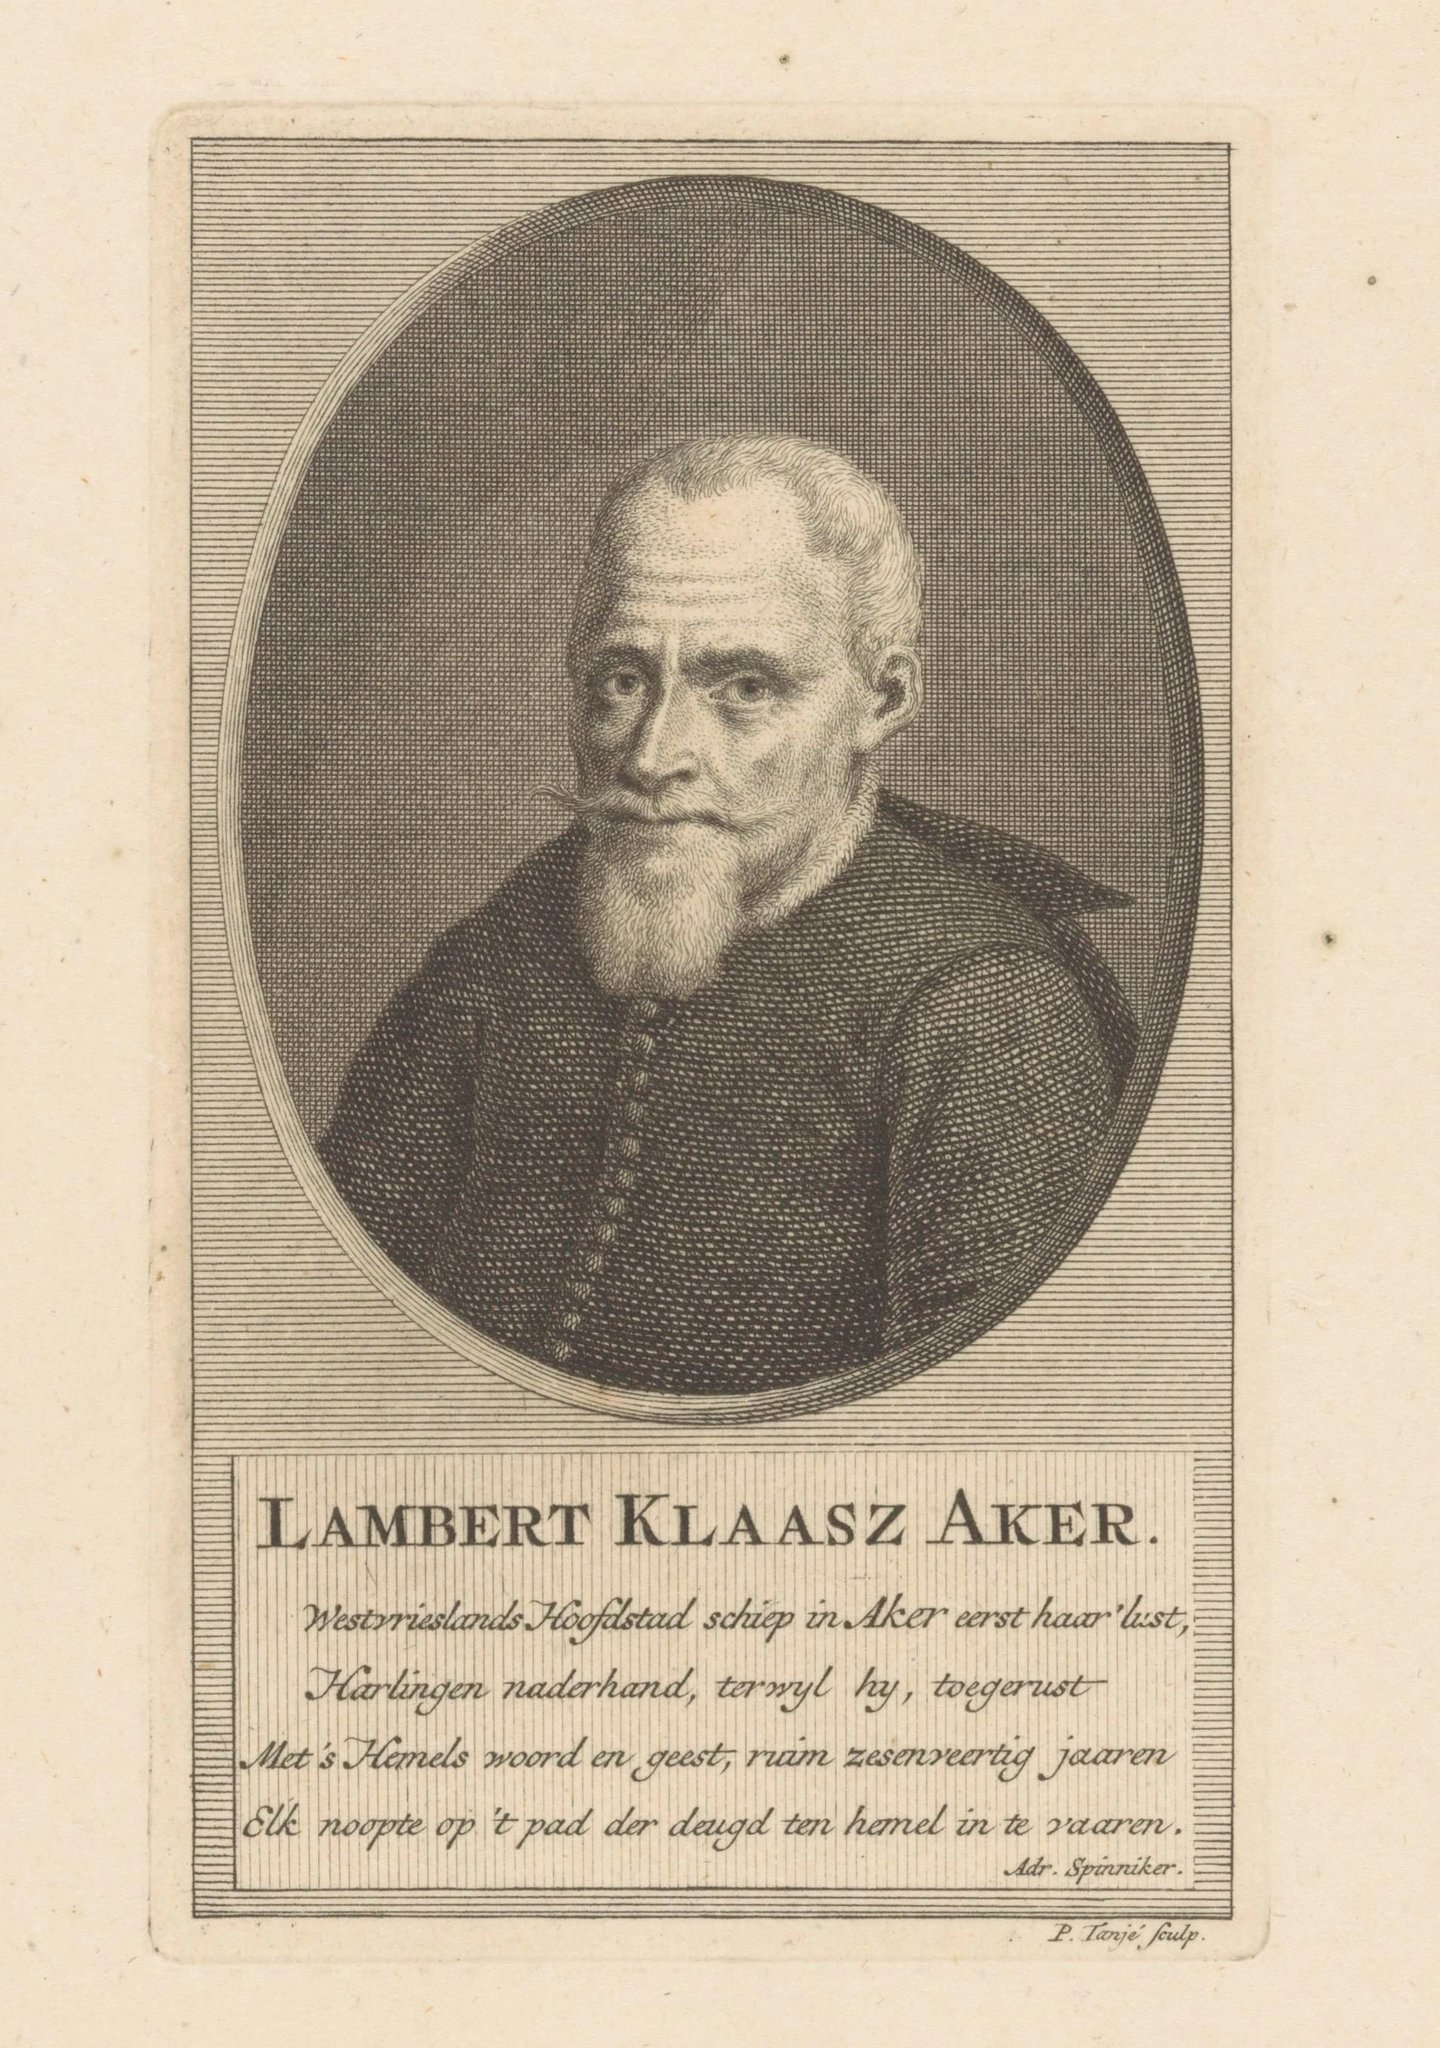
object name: print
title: Portret van Lambert Klaasz. Aker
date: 1716-1761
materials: paper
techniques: engraving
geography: amsterdam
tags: predikant, lambert klaasz. aker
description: Portret van Lambert Klaasz. Aker in een ovale omlijsting. In een kader zijn naam en vier regels Nederlandse tekst.